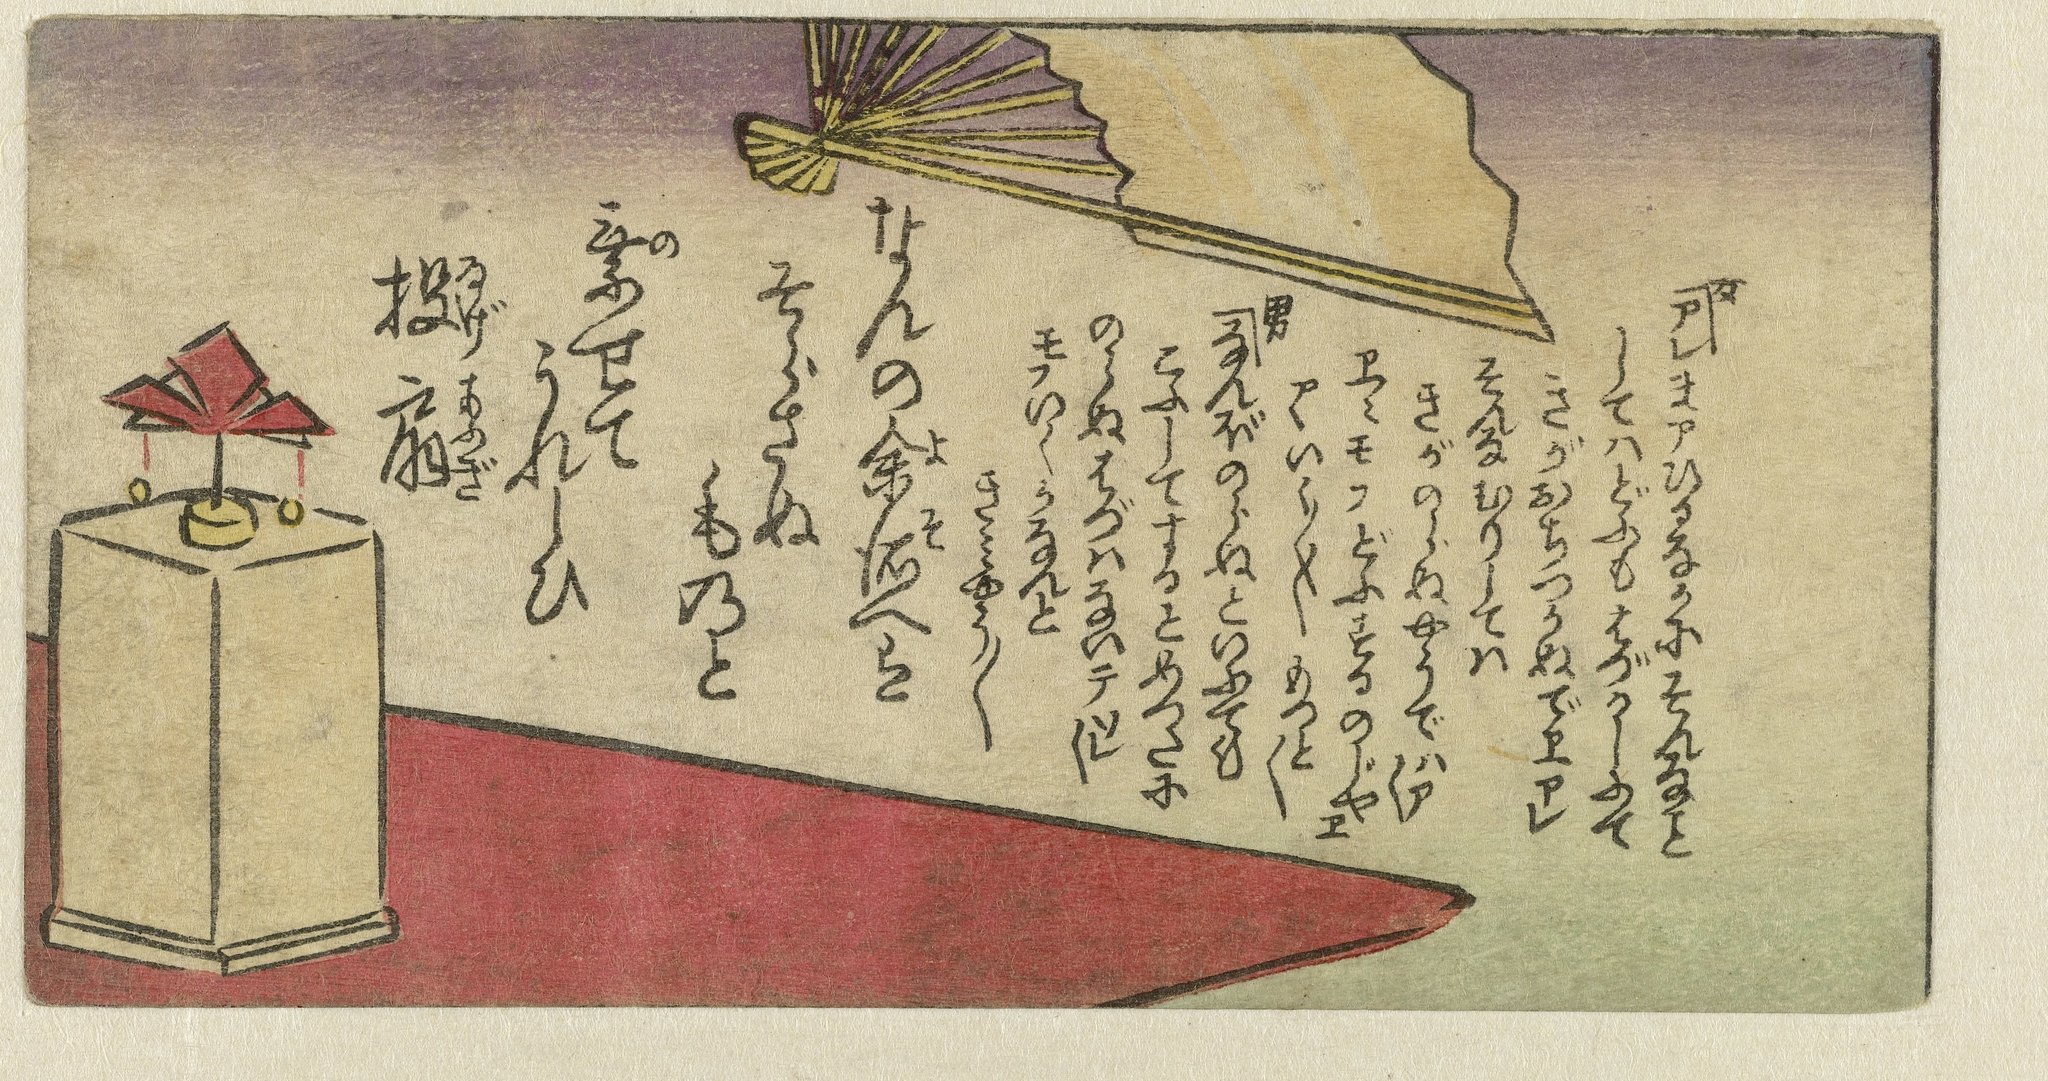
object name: print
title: Waaierserie met begeleidende prenten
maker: Anonymous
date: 1850-1860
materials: paper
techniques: woodcut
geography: japan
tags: varia (throwing games), oriental ideographic script (chinese, korean, japanese)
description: Nieuwjaarsspel, waarbij een waaier naar een object op een tafel wordt gegooid. Met een begleidende tekst bij de 'werp waaier'.